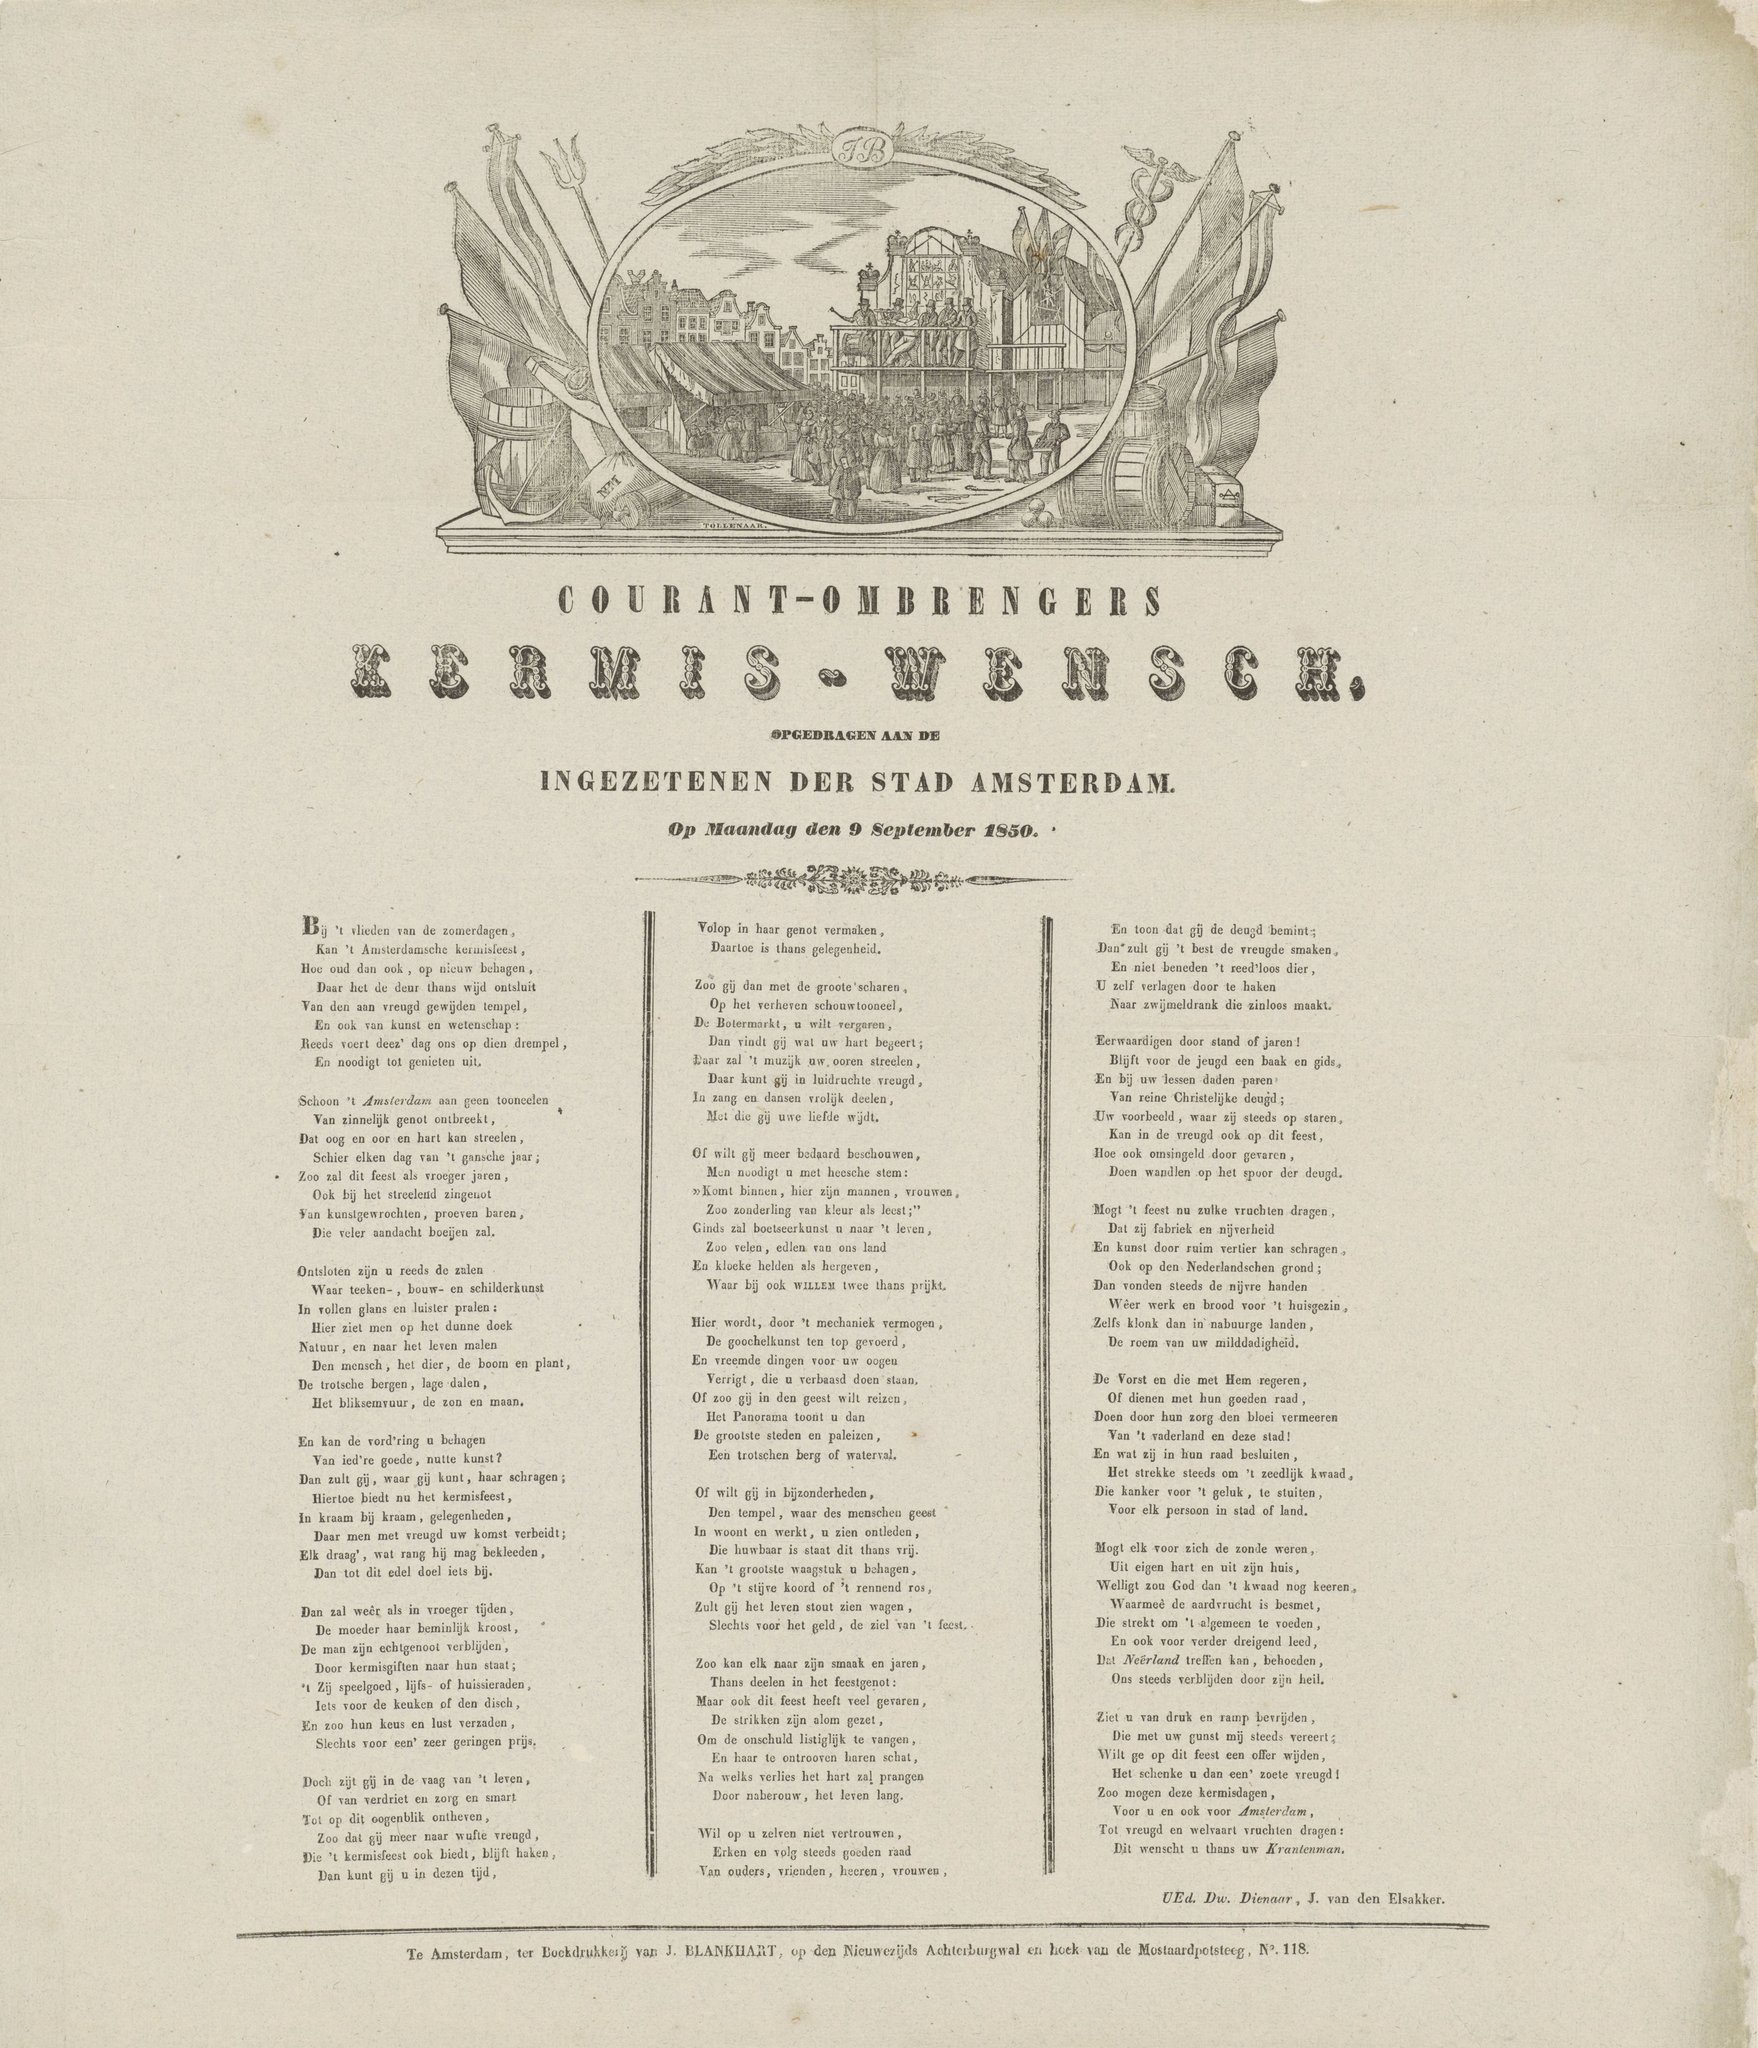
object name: fair print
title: Kermisprent van de Amsterdamse courantombrengers voor het jaar 1850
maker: dirk wijbrand tollenaar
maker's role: print maker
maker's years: 1808-1858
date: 1850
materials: paper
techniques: letterpress printing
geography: amsterdam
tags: pleasure fair and circus, amsterdam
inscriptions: collector's mark: Lugt 2228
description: Kermisprent namens de ombrengers van couranten (krantenbezorgers) te Amsterdam, 9 september 1850. Bovenaan een medaillon met een gezicht op de kermis op de Botermarkt. Onderaan een gedicht in drie kolommen. Van de courantombrenger: J. van den Elsakker.